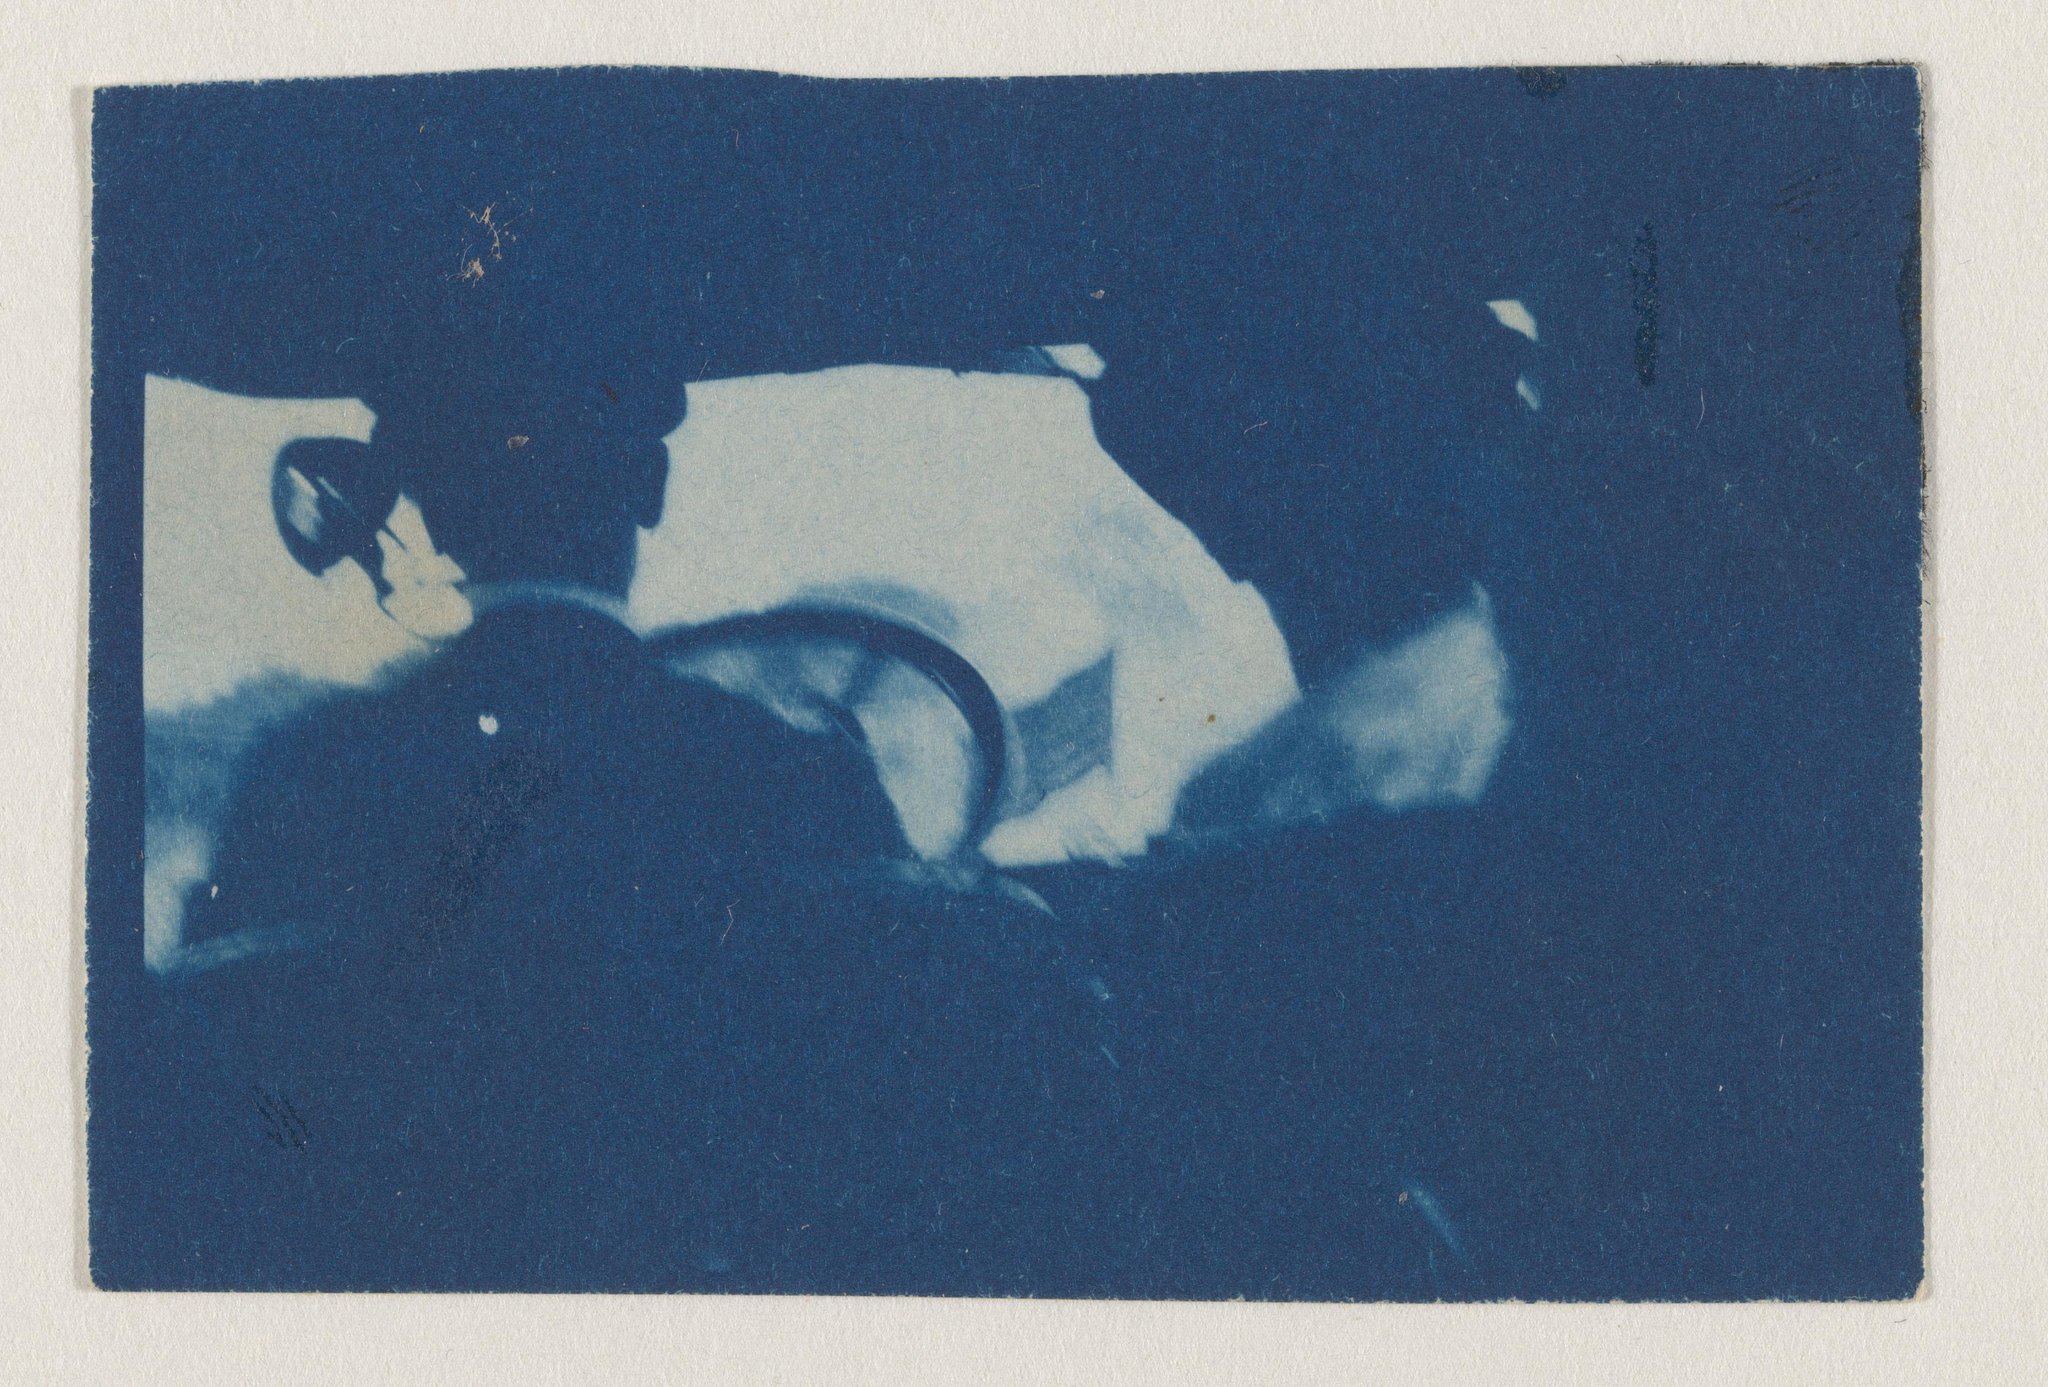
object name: photograph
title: Gezicht gefotografeerd vanuit een auto, met chauffeur en passagier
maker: Anonymous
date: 1910-1930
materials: paper, photographic support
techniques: cyanotype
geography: united states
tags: united states of america